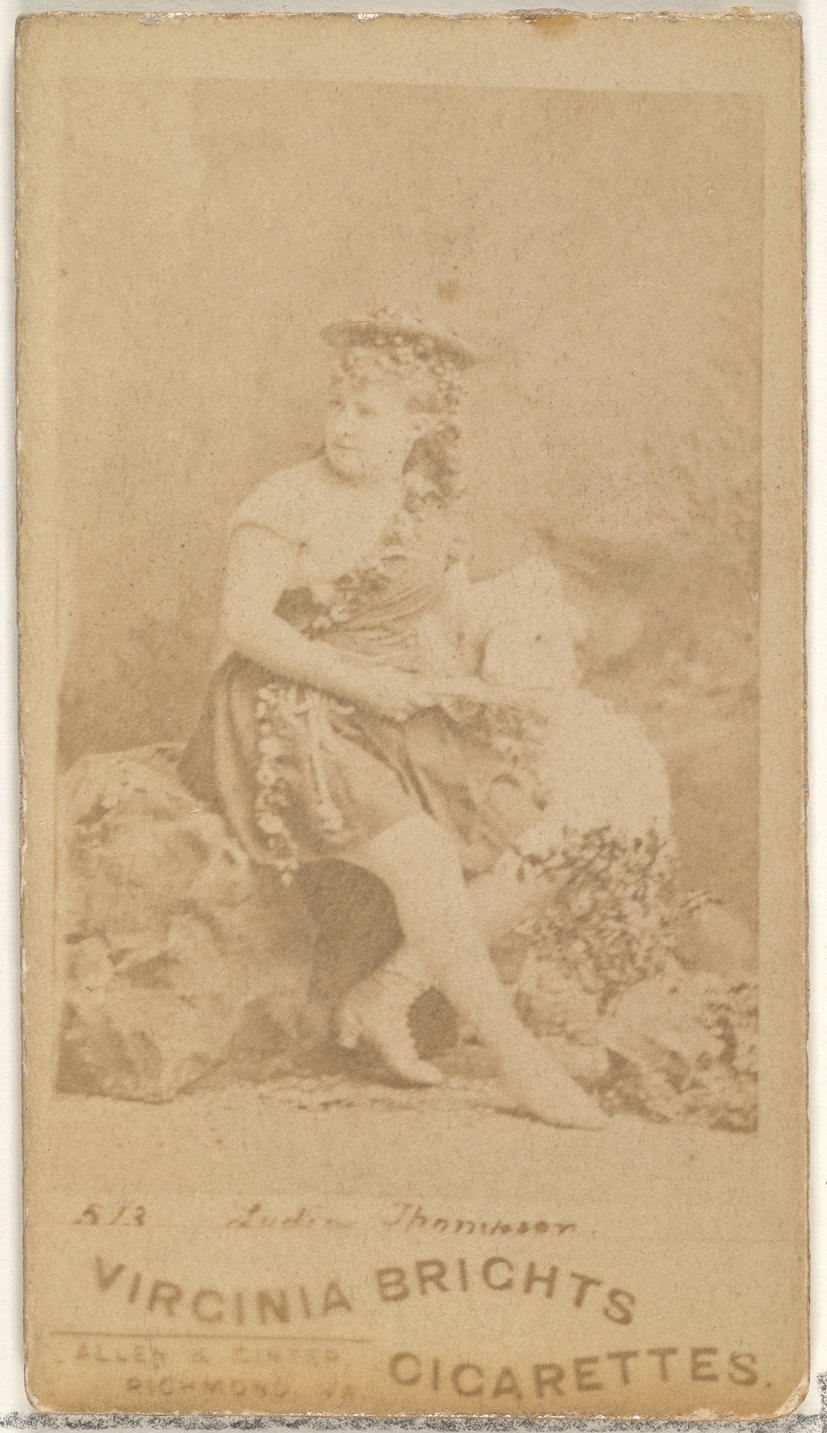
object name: photograph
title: Card 523, Lydia Thompson, from the Actors and Actresses series (N45, Type 1) for Virginia Brights Cigarettes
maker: allen & ginter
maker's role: publisher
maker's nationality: american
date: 1888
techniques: albumen silver print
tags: portraits,women,actresses